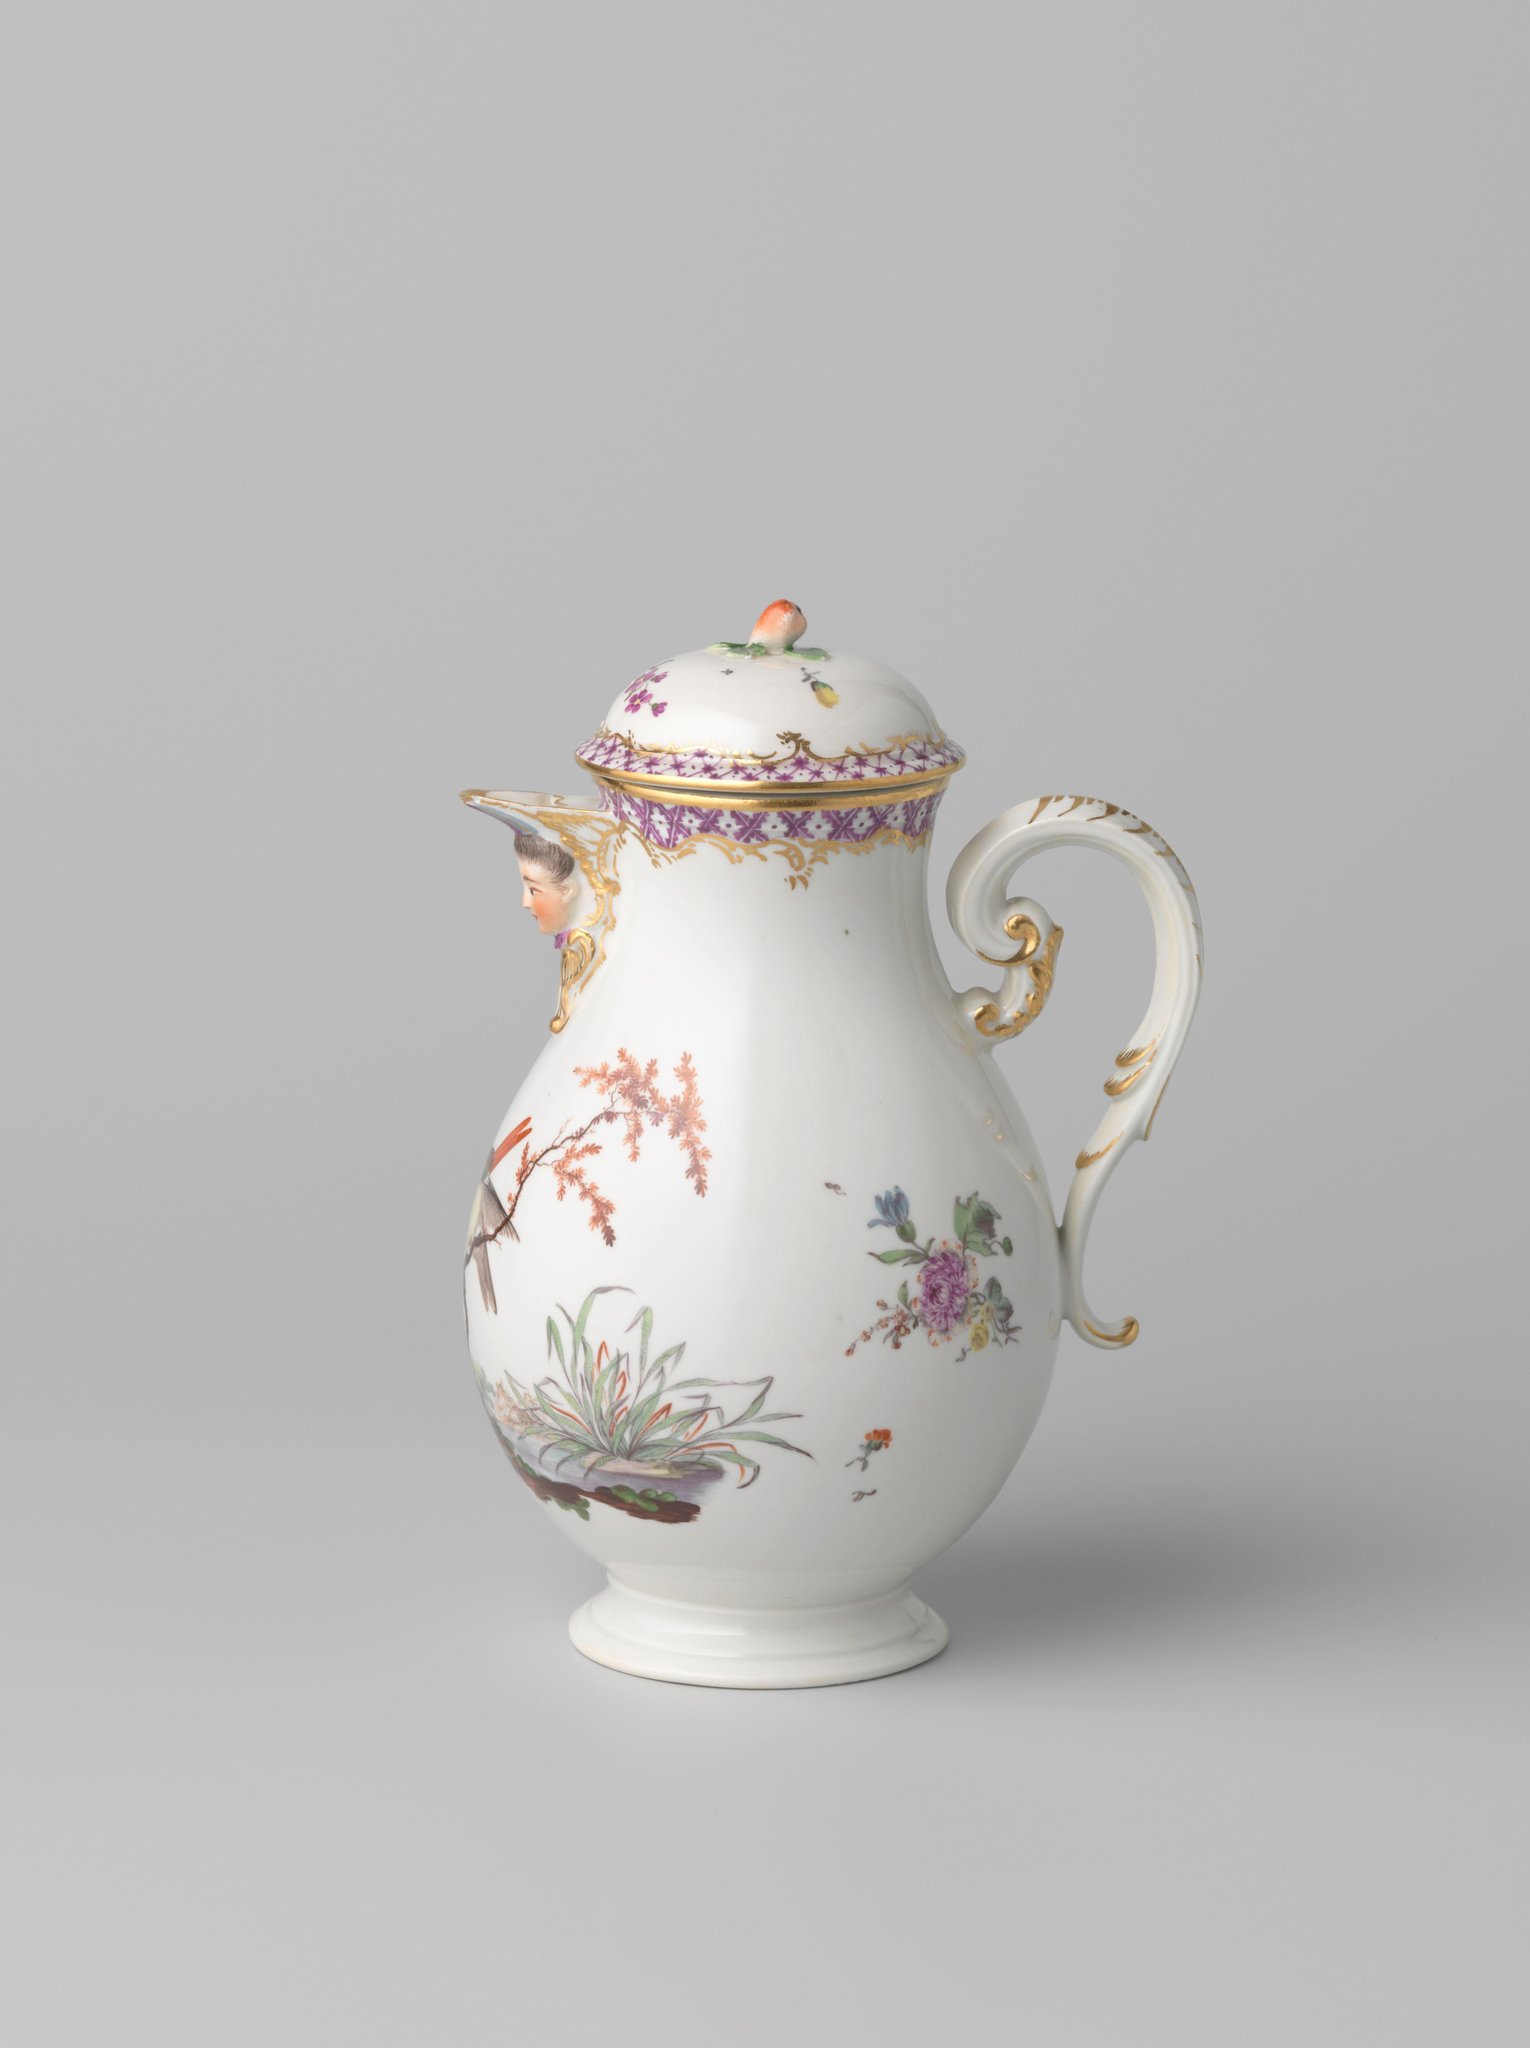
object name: coffee pot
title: Coffeepot with birds in a landscape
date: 1765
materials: glaze, gold, paint, porcelain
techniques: firing, forming, gilding, turning, vitrification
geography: ansbach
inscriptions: mark: ‘A/ I/ 4’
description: Koffiekan van porselein op spreidende voet met een peervormig lichaam, driehoekige tuit vanuit de nek en een gekruld oor in de vorm van een bladrank. Beschilderd op het glazuur in emailkleuren en goud. Op de buik drie vogels in een landschap, waarbij twee op een tak zitten en één op de grond. Aan weerszijden hiervan een boeket en strooibloemen. Op de rand een band met servetwerk, waaronder gouden ranken. De tuit is gemodelleerd in een engelenkop met vleugels. Het gekrulde oor is aangezet met goud en eindigd in een palmet. Gemerkt op de onderzijde met de A, I en 4.